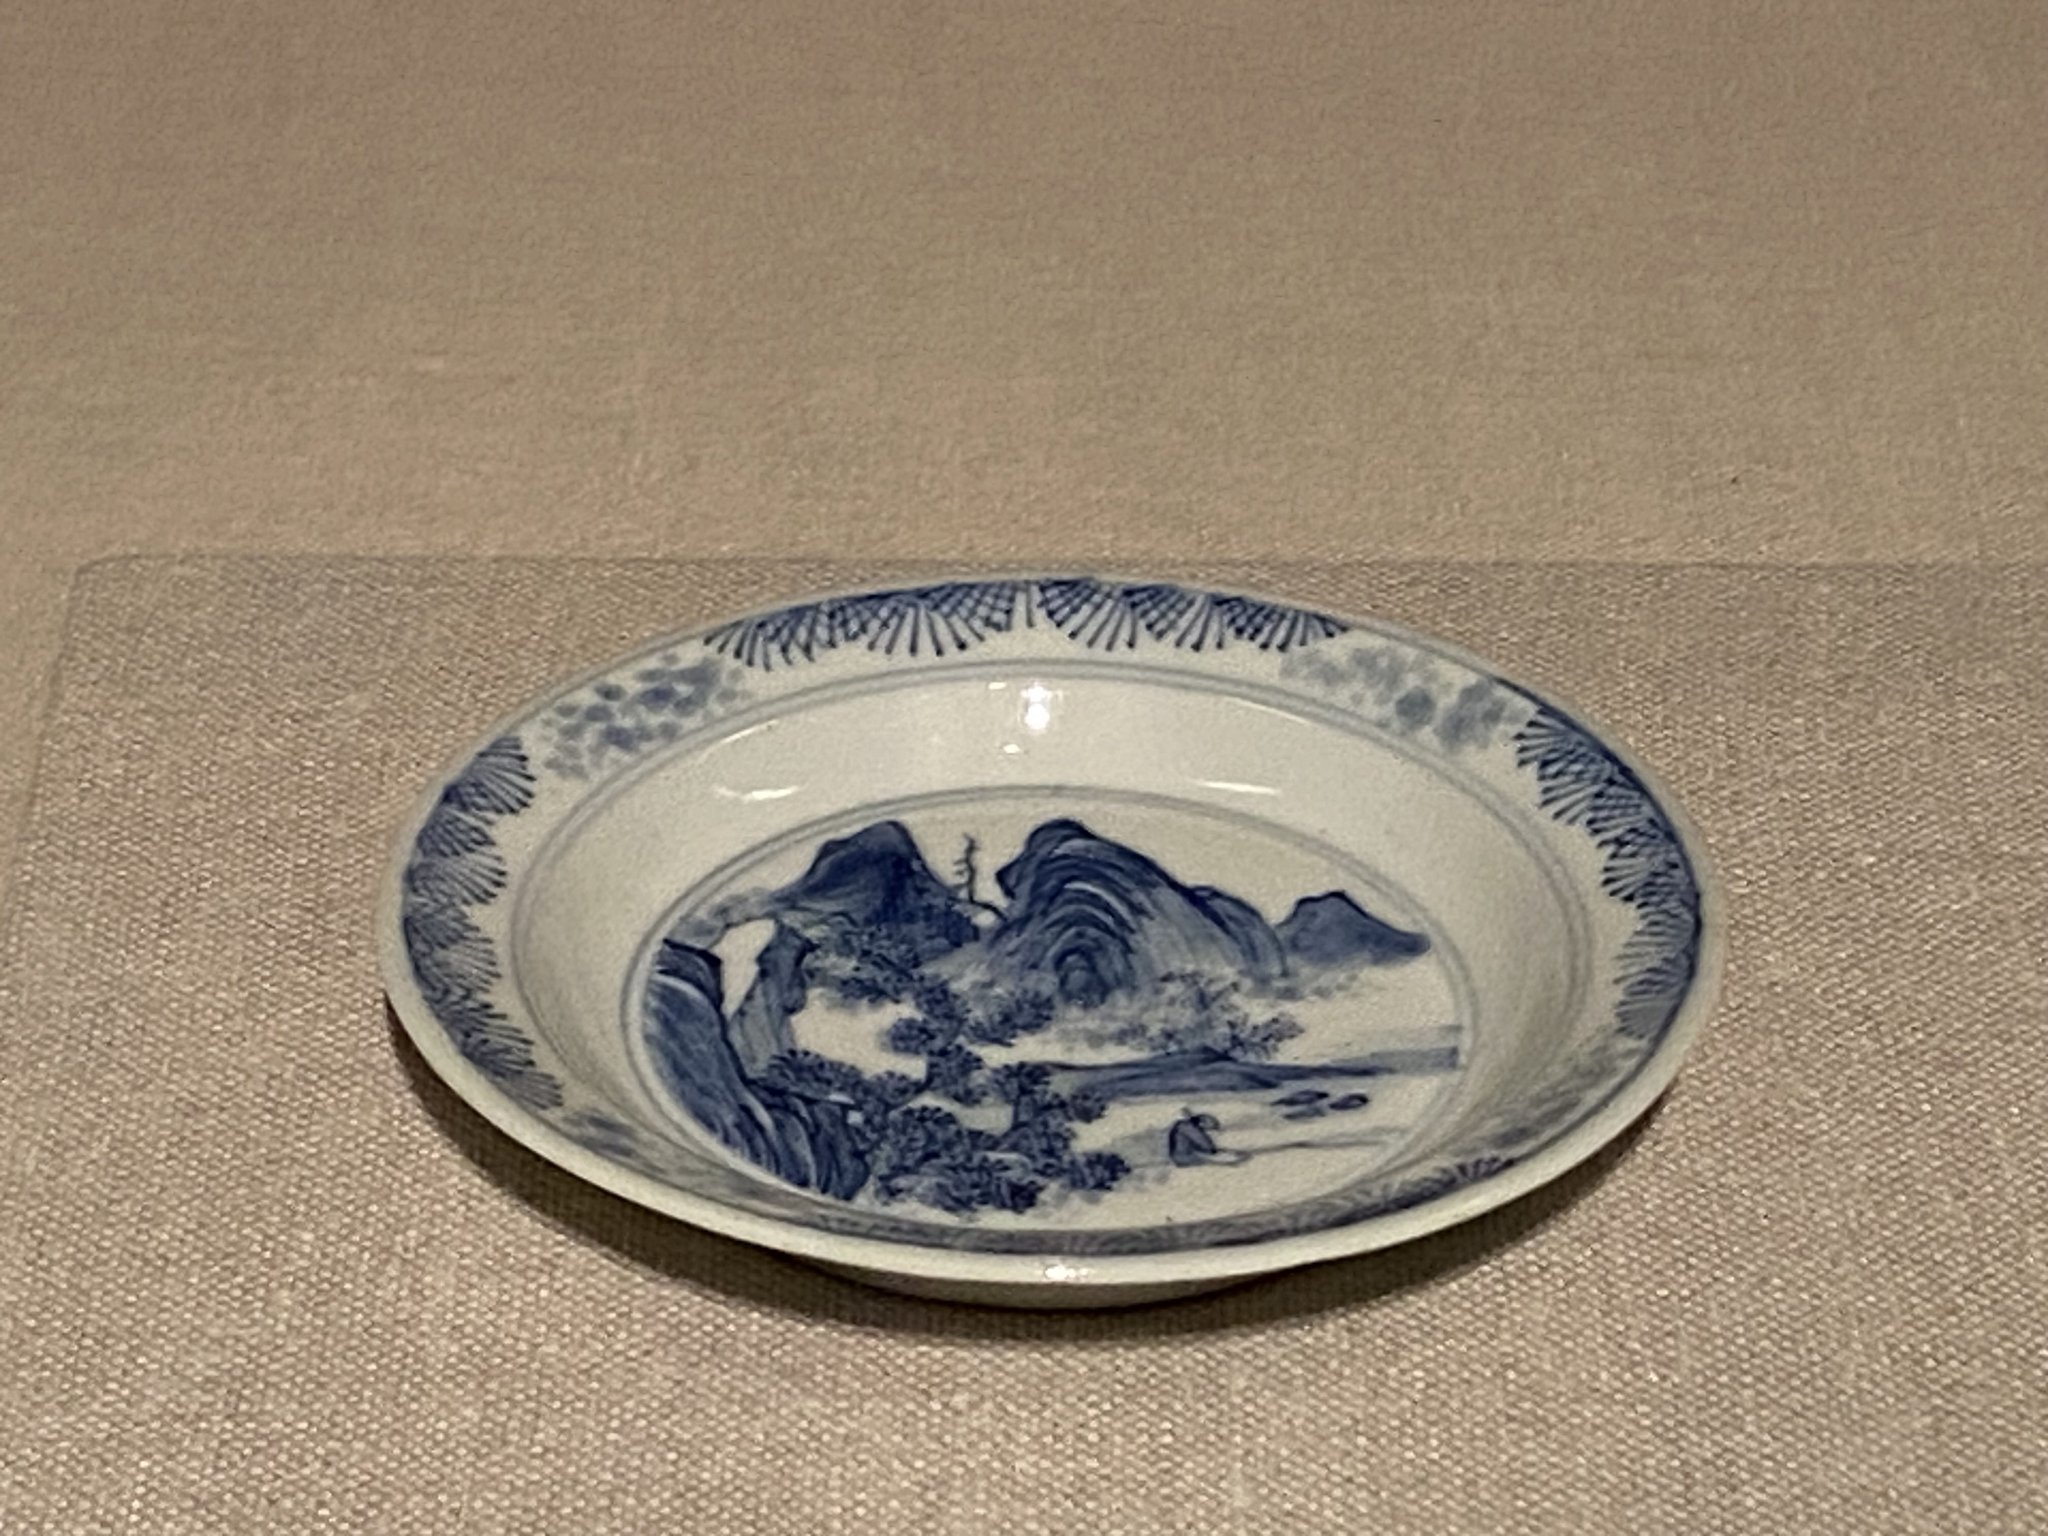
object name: saucer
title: Saucer with landscape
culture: chinese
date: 1667-1700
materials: cobalt, porcelain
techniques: painting, underglaze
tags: landscapes